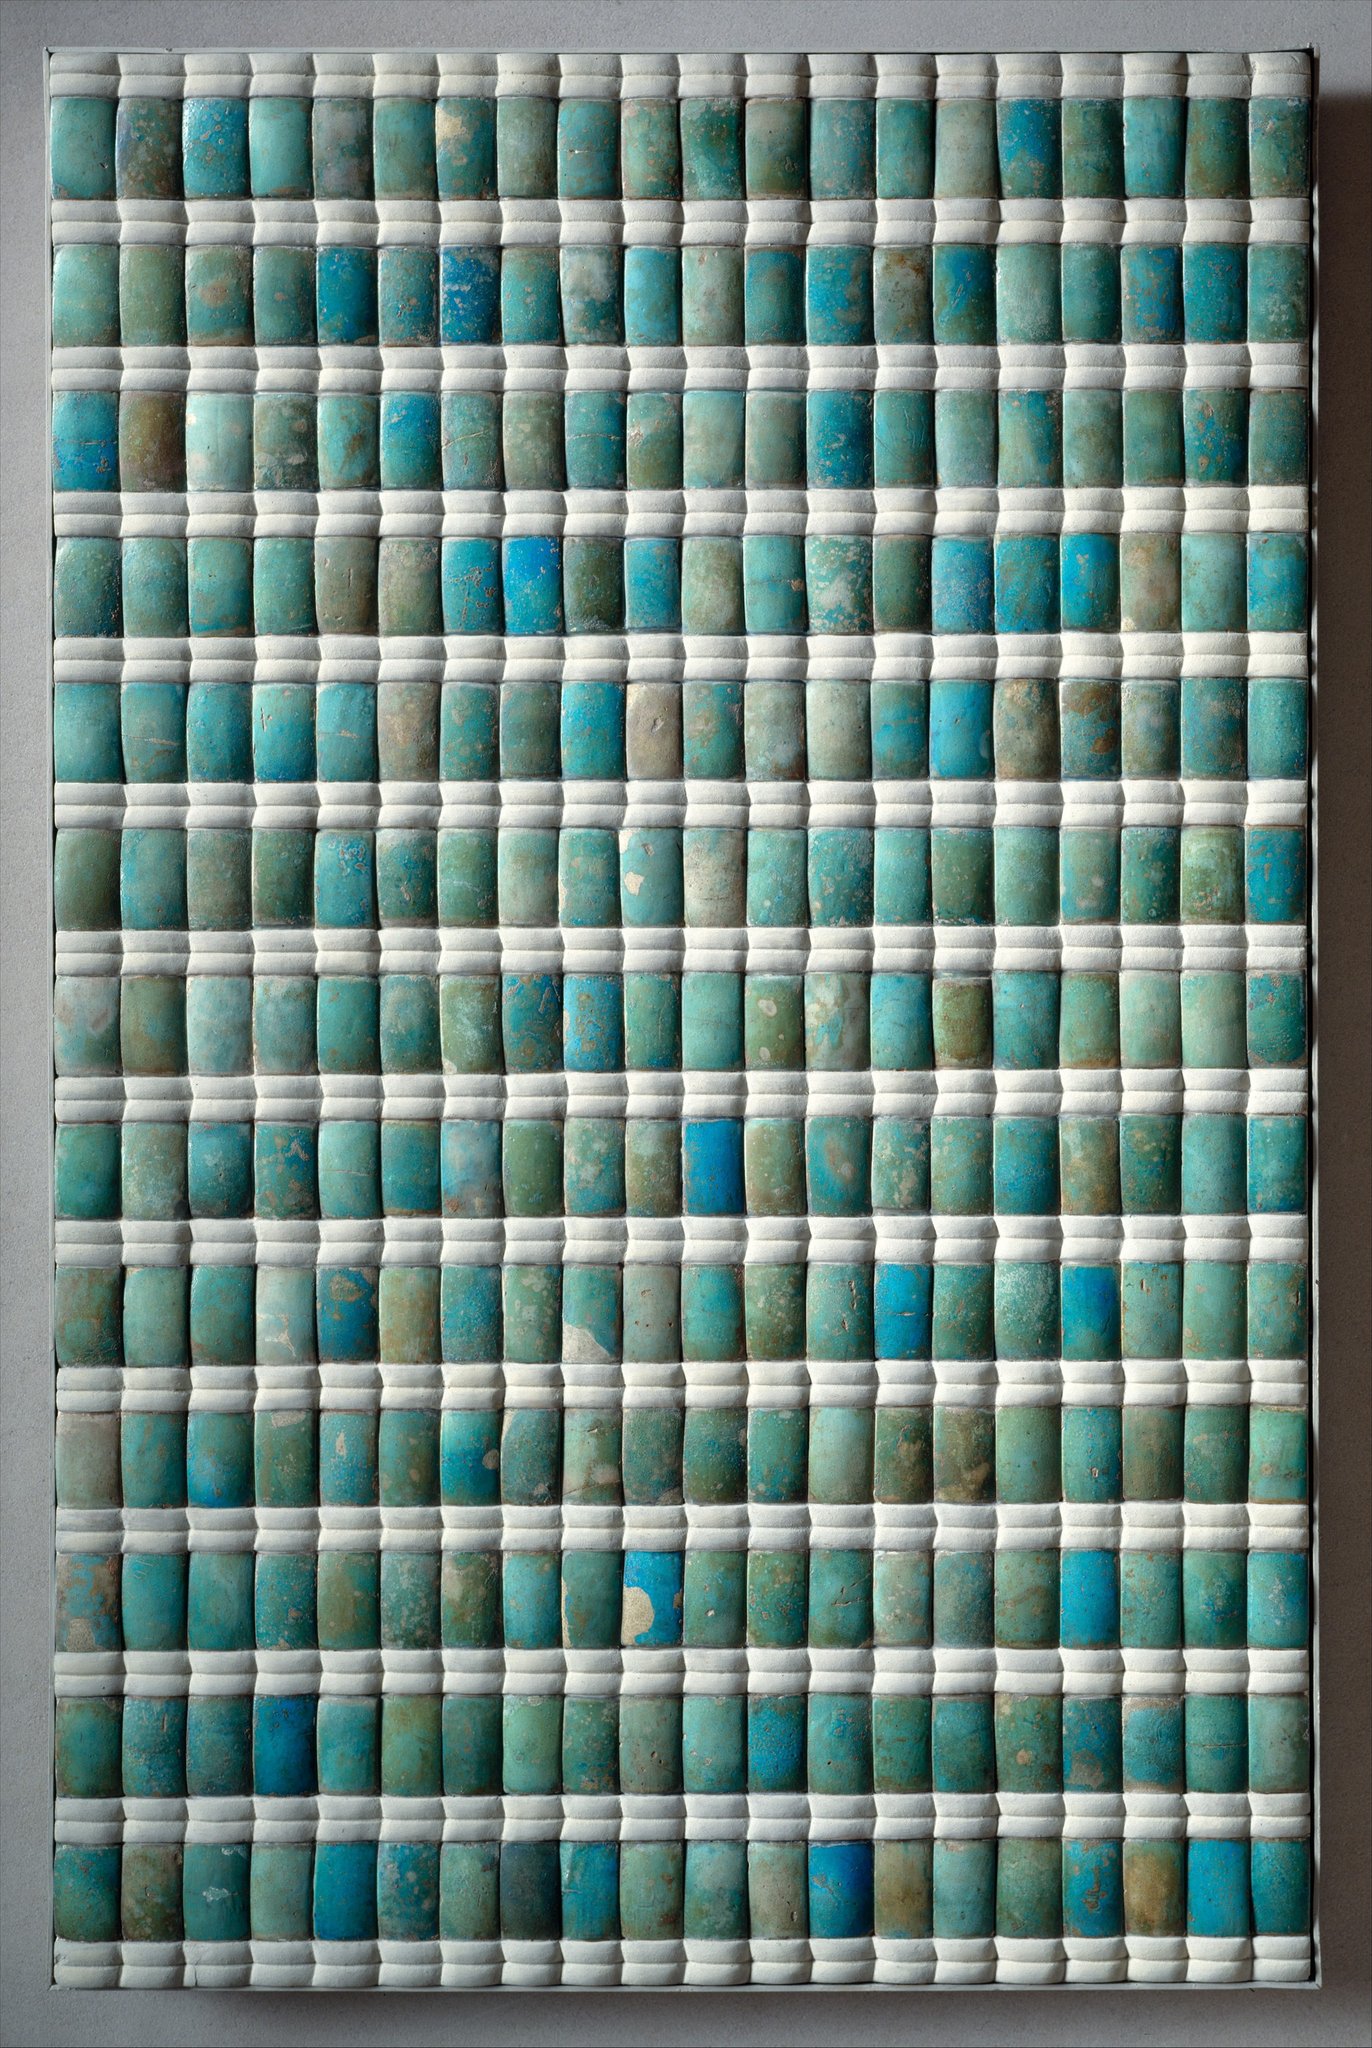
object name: tile, apartment of king djoser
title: Wall tiles from the funerary apartments of king Djoser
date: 2630-2611 BCE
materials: faience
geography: egypt